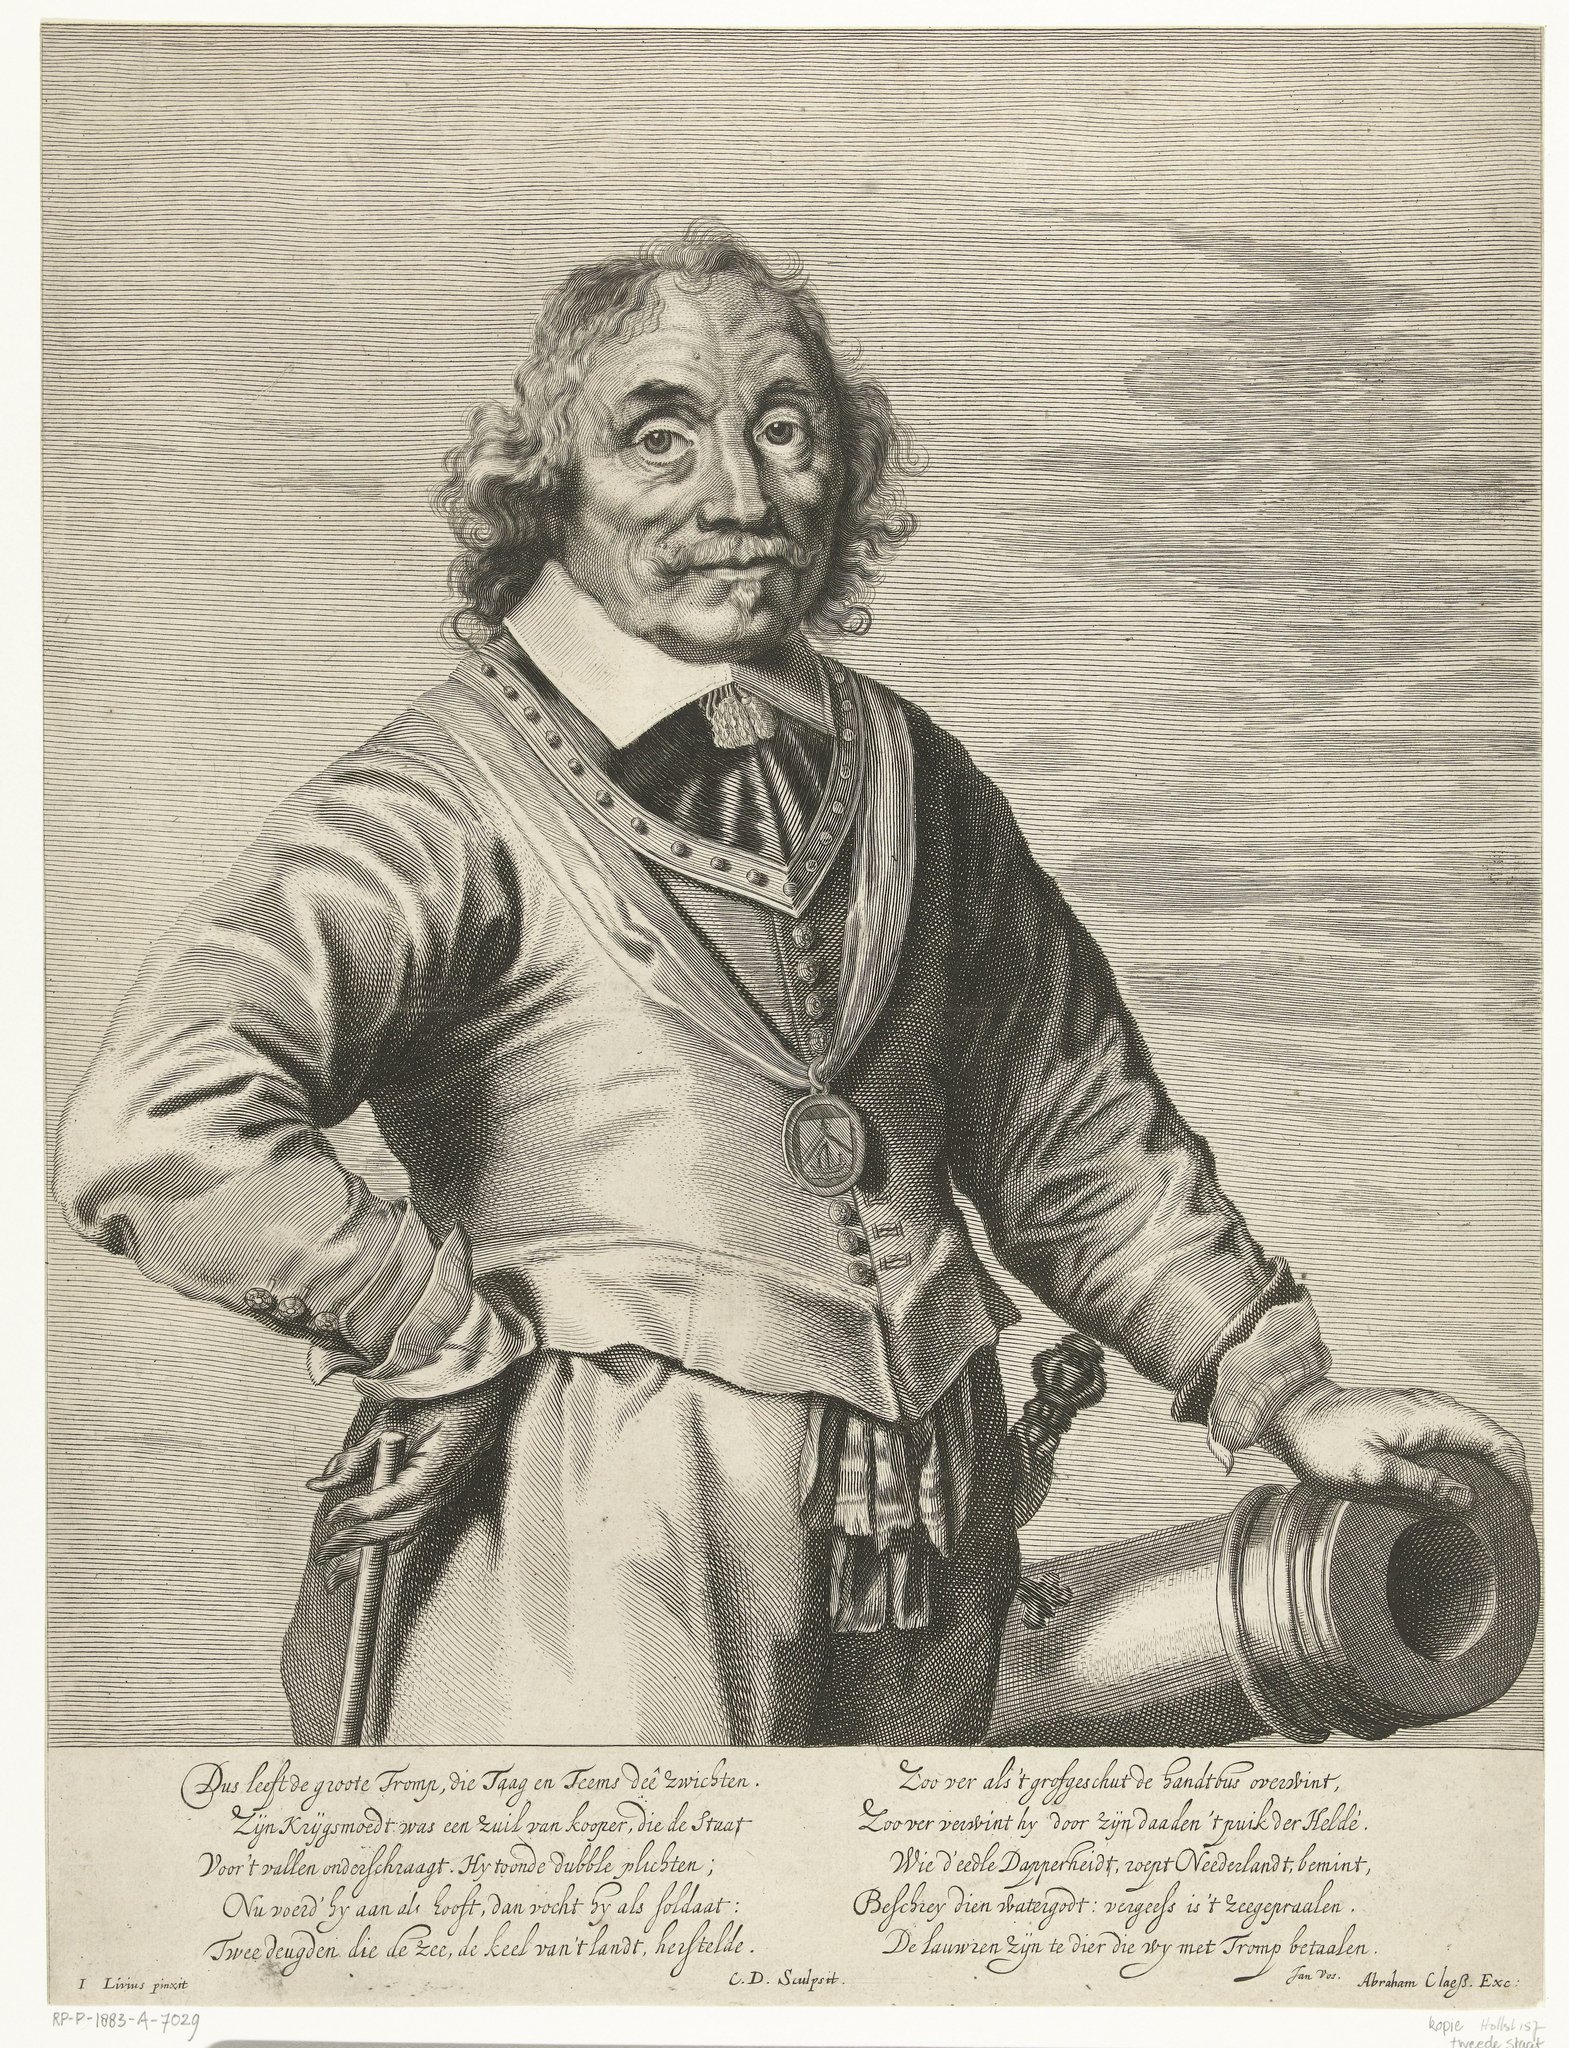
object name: print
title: Portret van Maarten Harpertszoon Tromp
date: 1648-1664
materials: paper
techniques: engraving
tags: brielle, maarten harpertszoon tromp, historical persons, commander-in-chief, admiral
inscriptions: collector's mark: Lugt 2228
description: Prent naar schilderij van Jan Lievens. Hollstein beschrijft de prent als een eerste staat maar het betreft een kopie in de tweede staat.